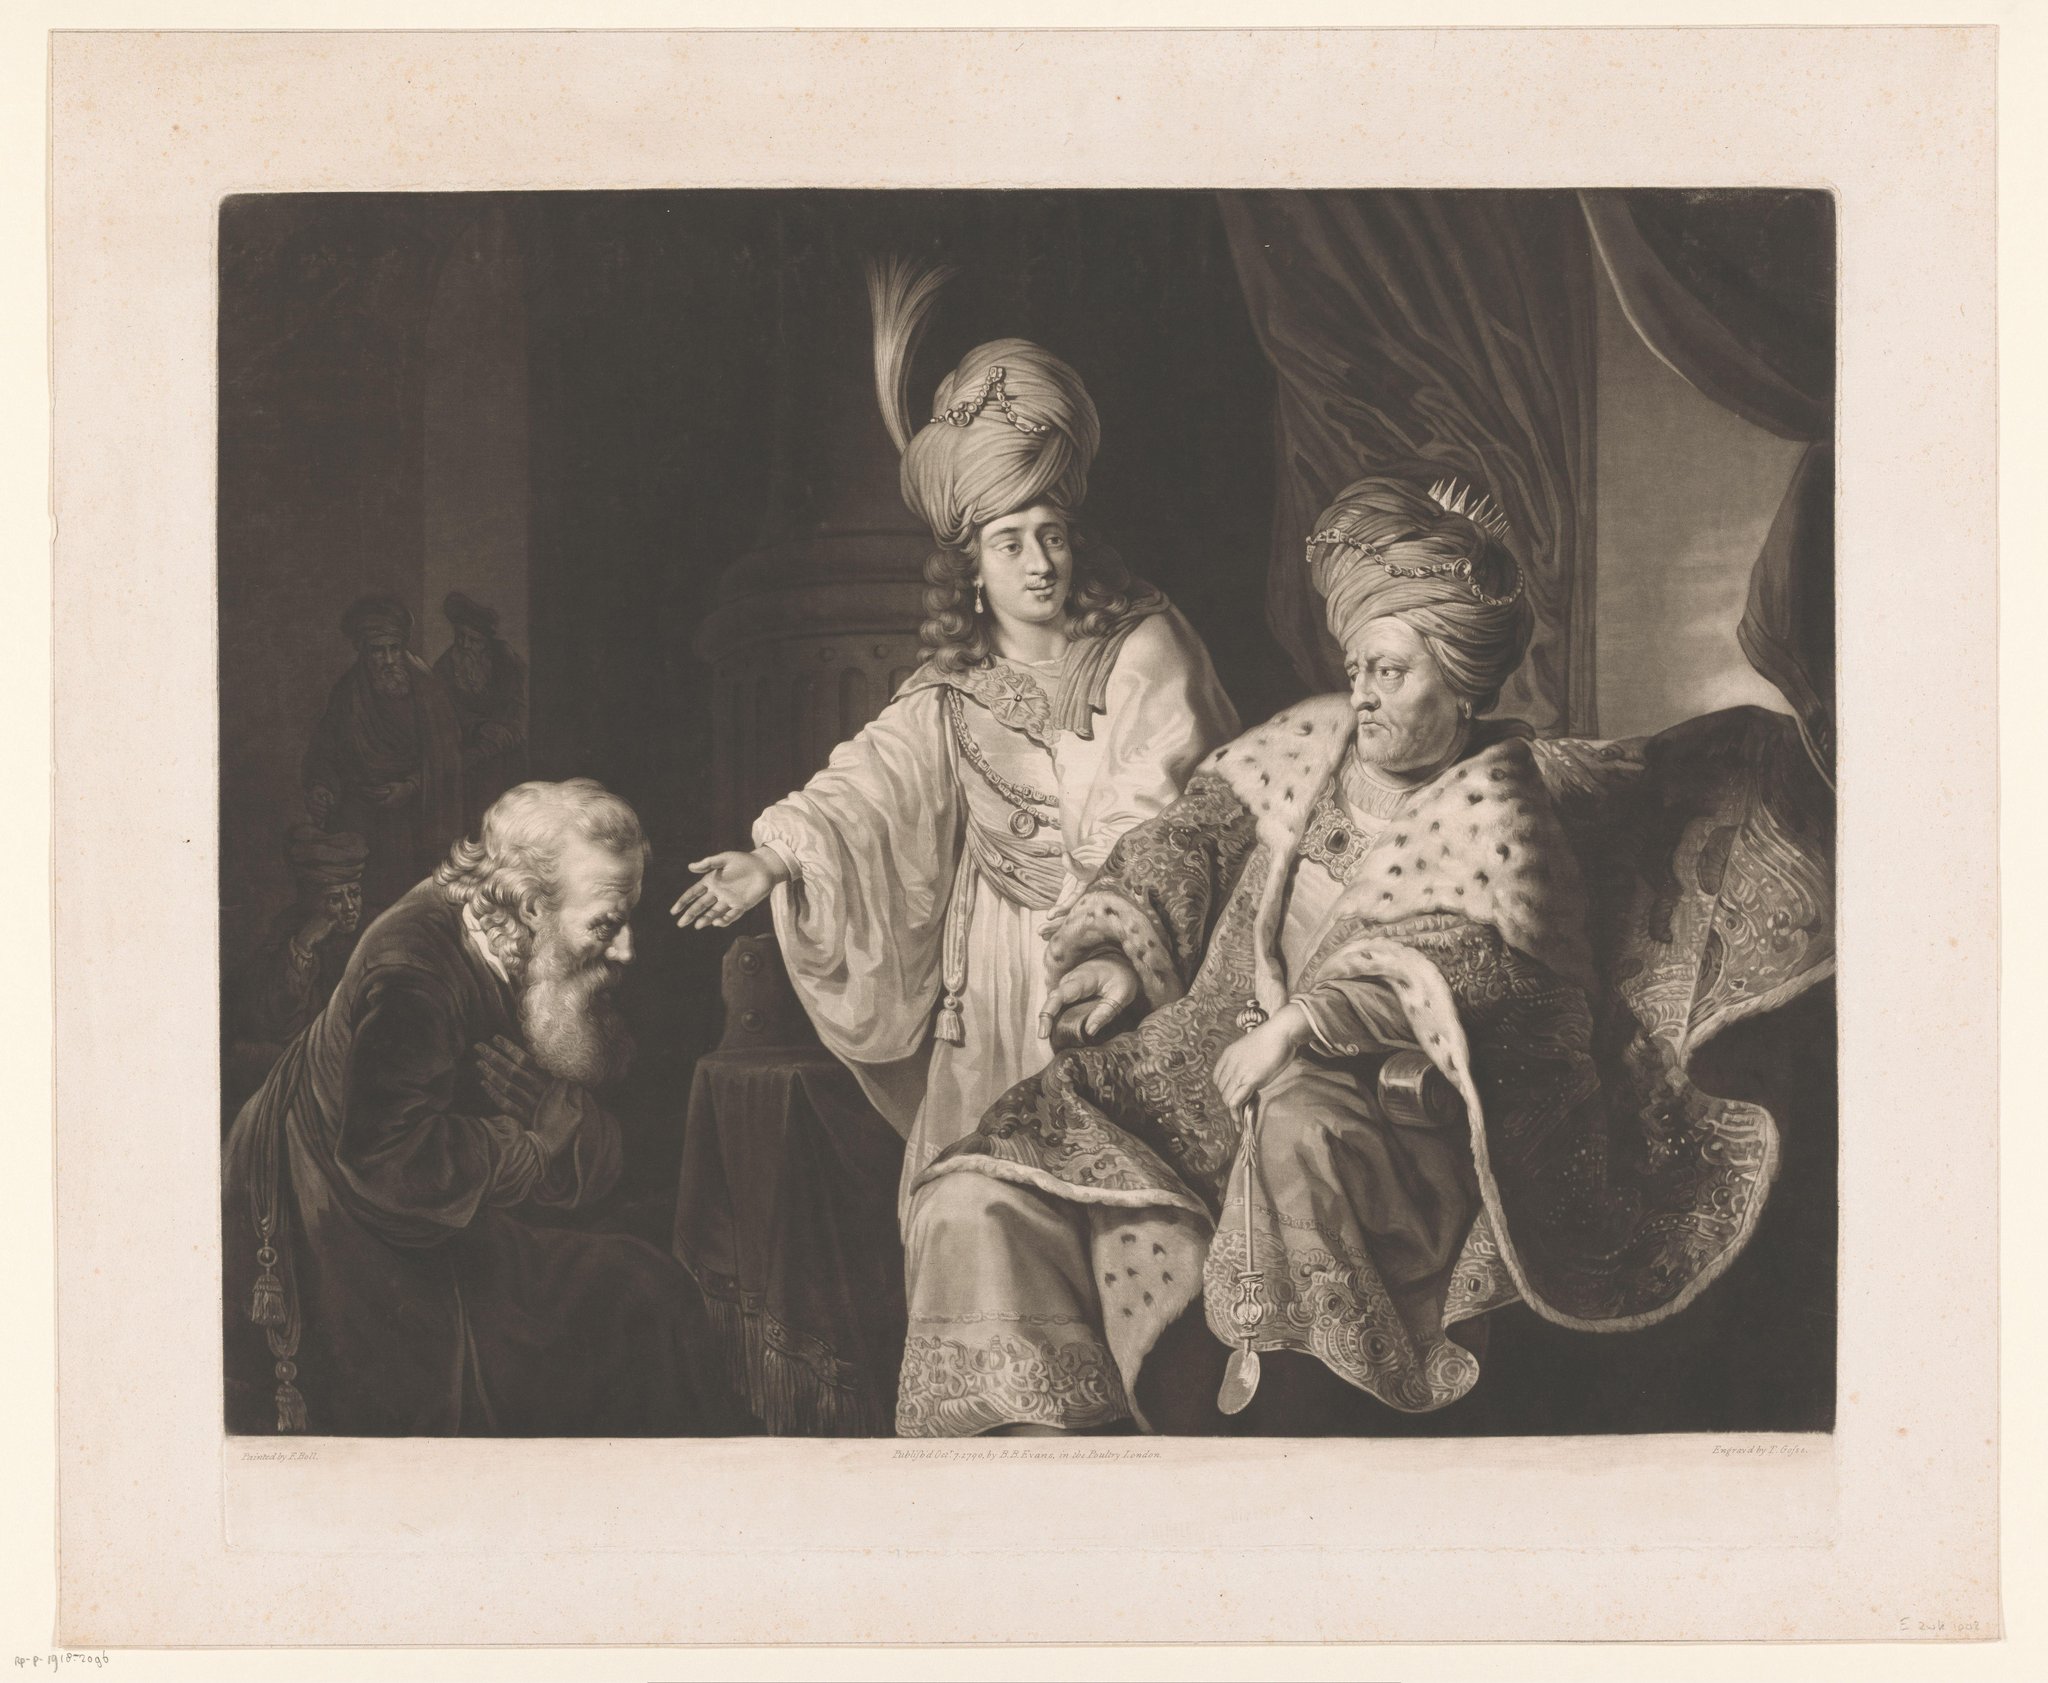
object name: print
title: Jozef stelt zijn vader aan de Farao voor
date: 1710-1790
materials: paper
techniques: mezzotint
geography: london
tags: jacob is presented to pharaoh by joseph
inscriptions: collector's mark: Lugt 2233